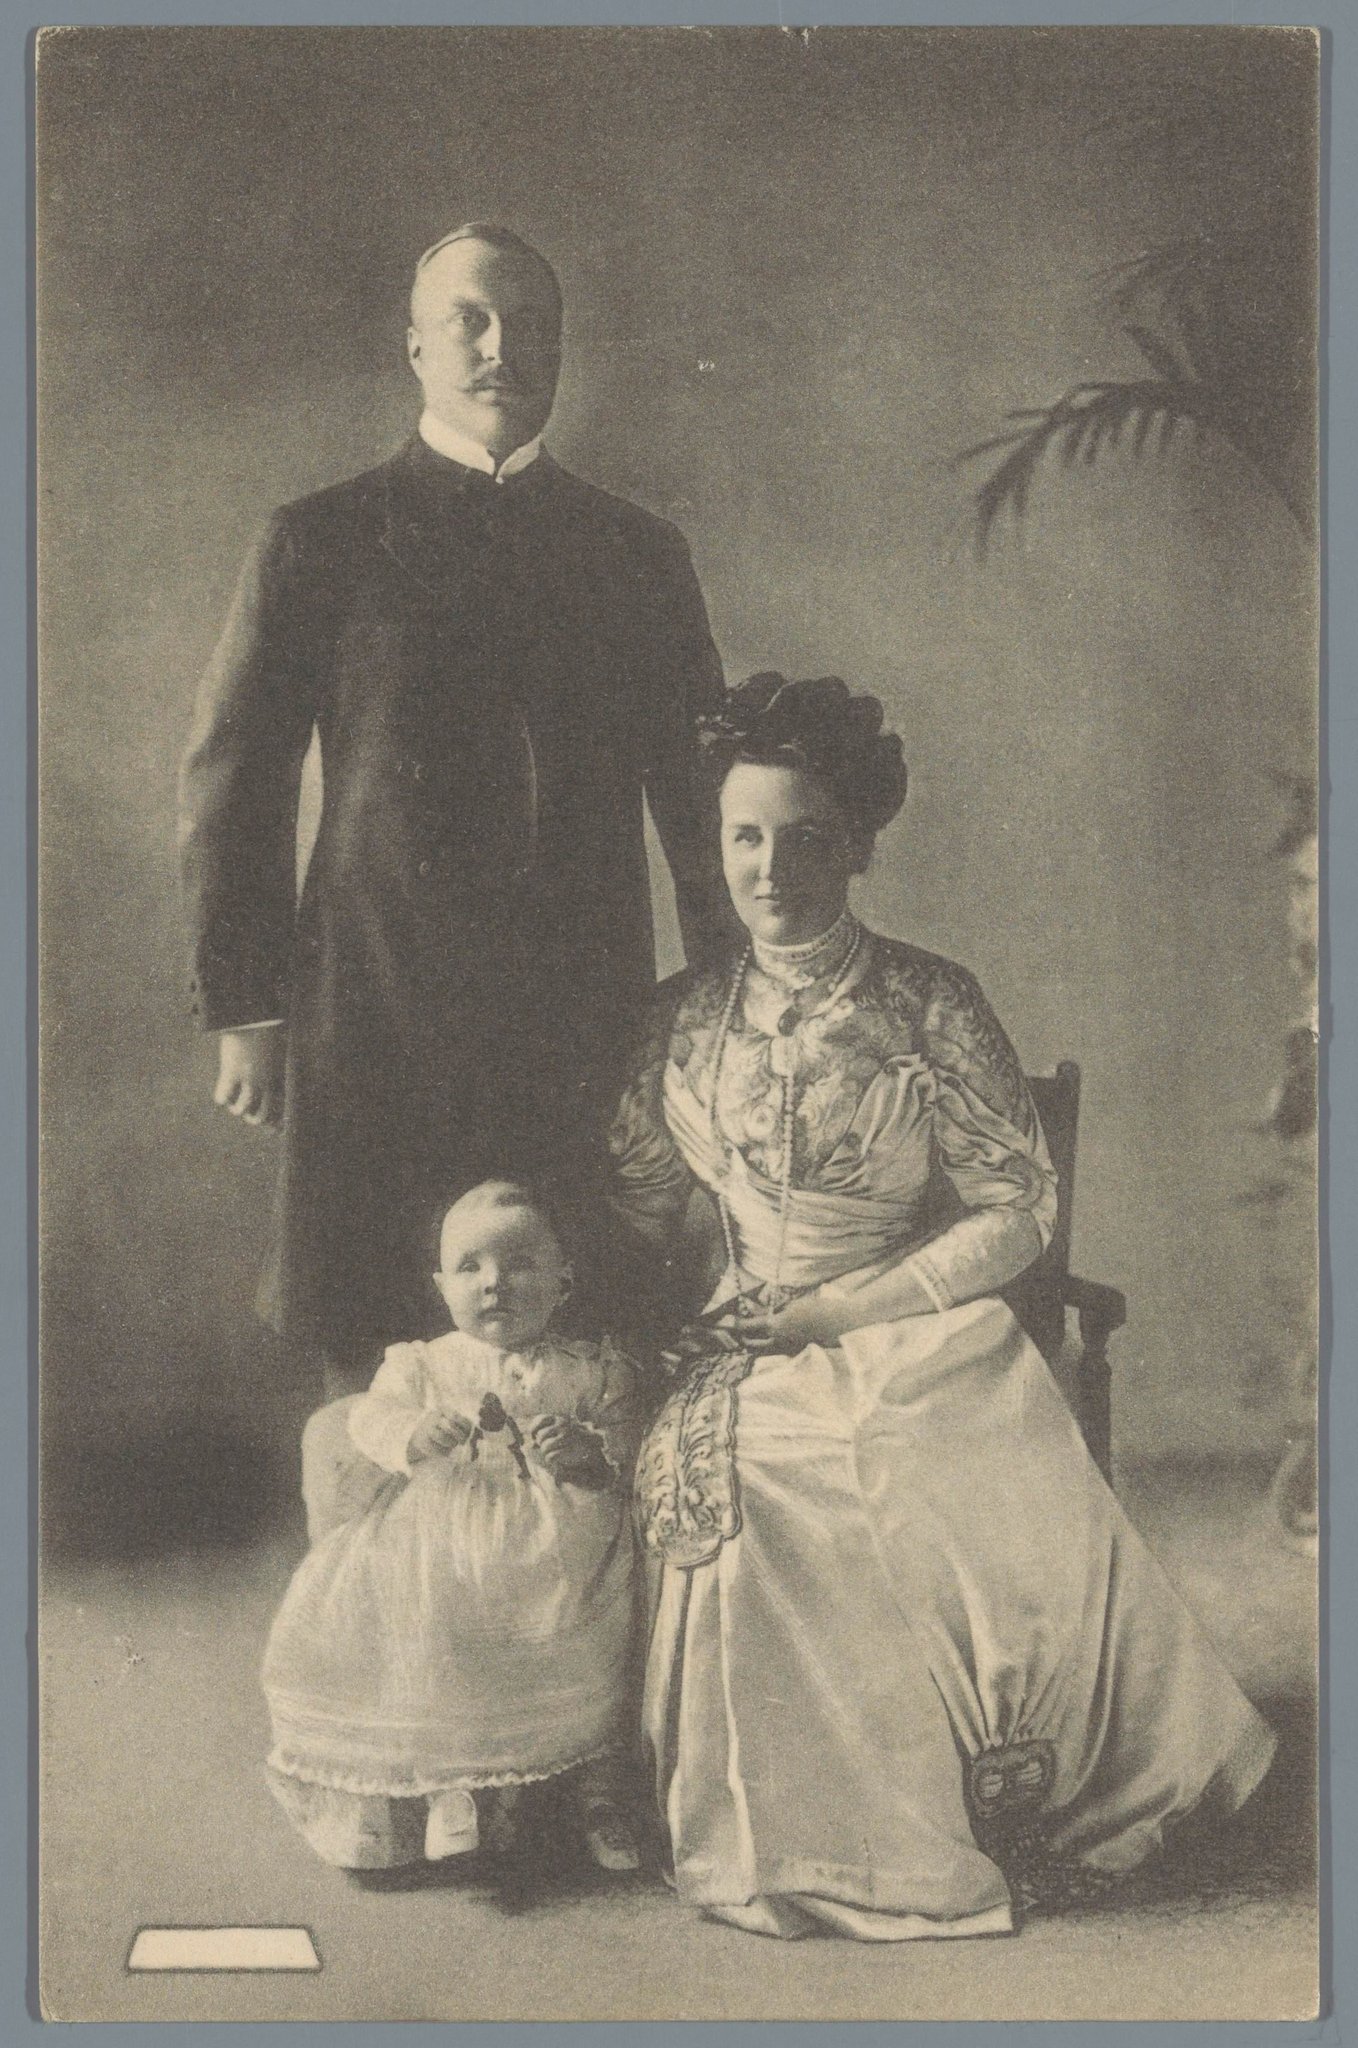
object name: photomechanical print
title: Portret van koningin Wilhelmina, prins Hendrik en prinses Juliana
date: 1911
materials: cardboard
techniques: photograph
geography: amsterdam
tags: the hague, print maker, wilhelmina of the netherlands, hendrik (prins der nederlanden (1876-1934)), juliana of the netherlands, crown princess, prince, historical persons, queen